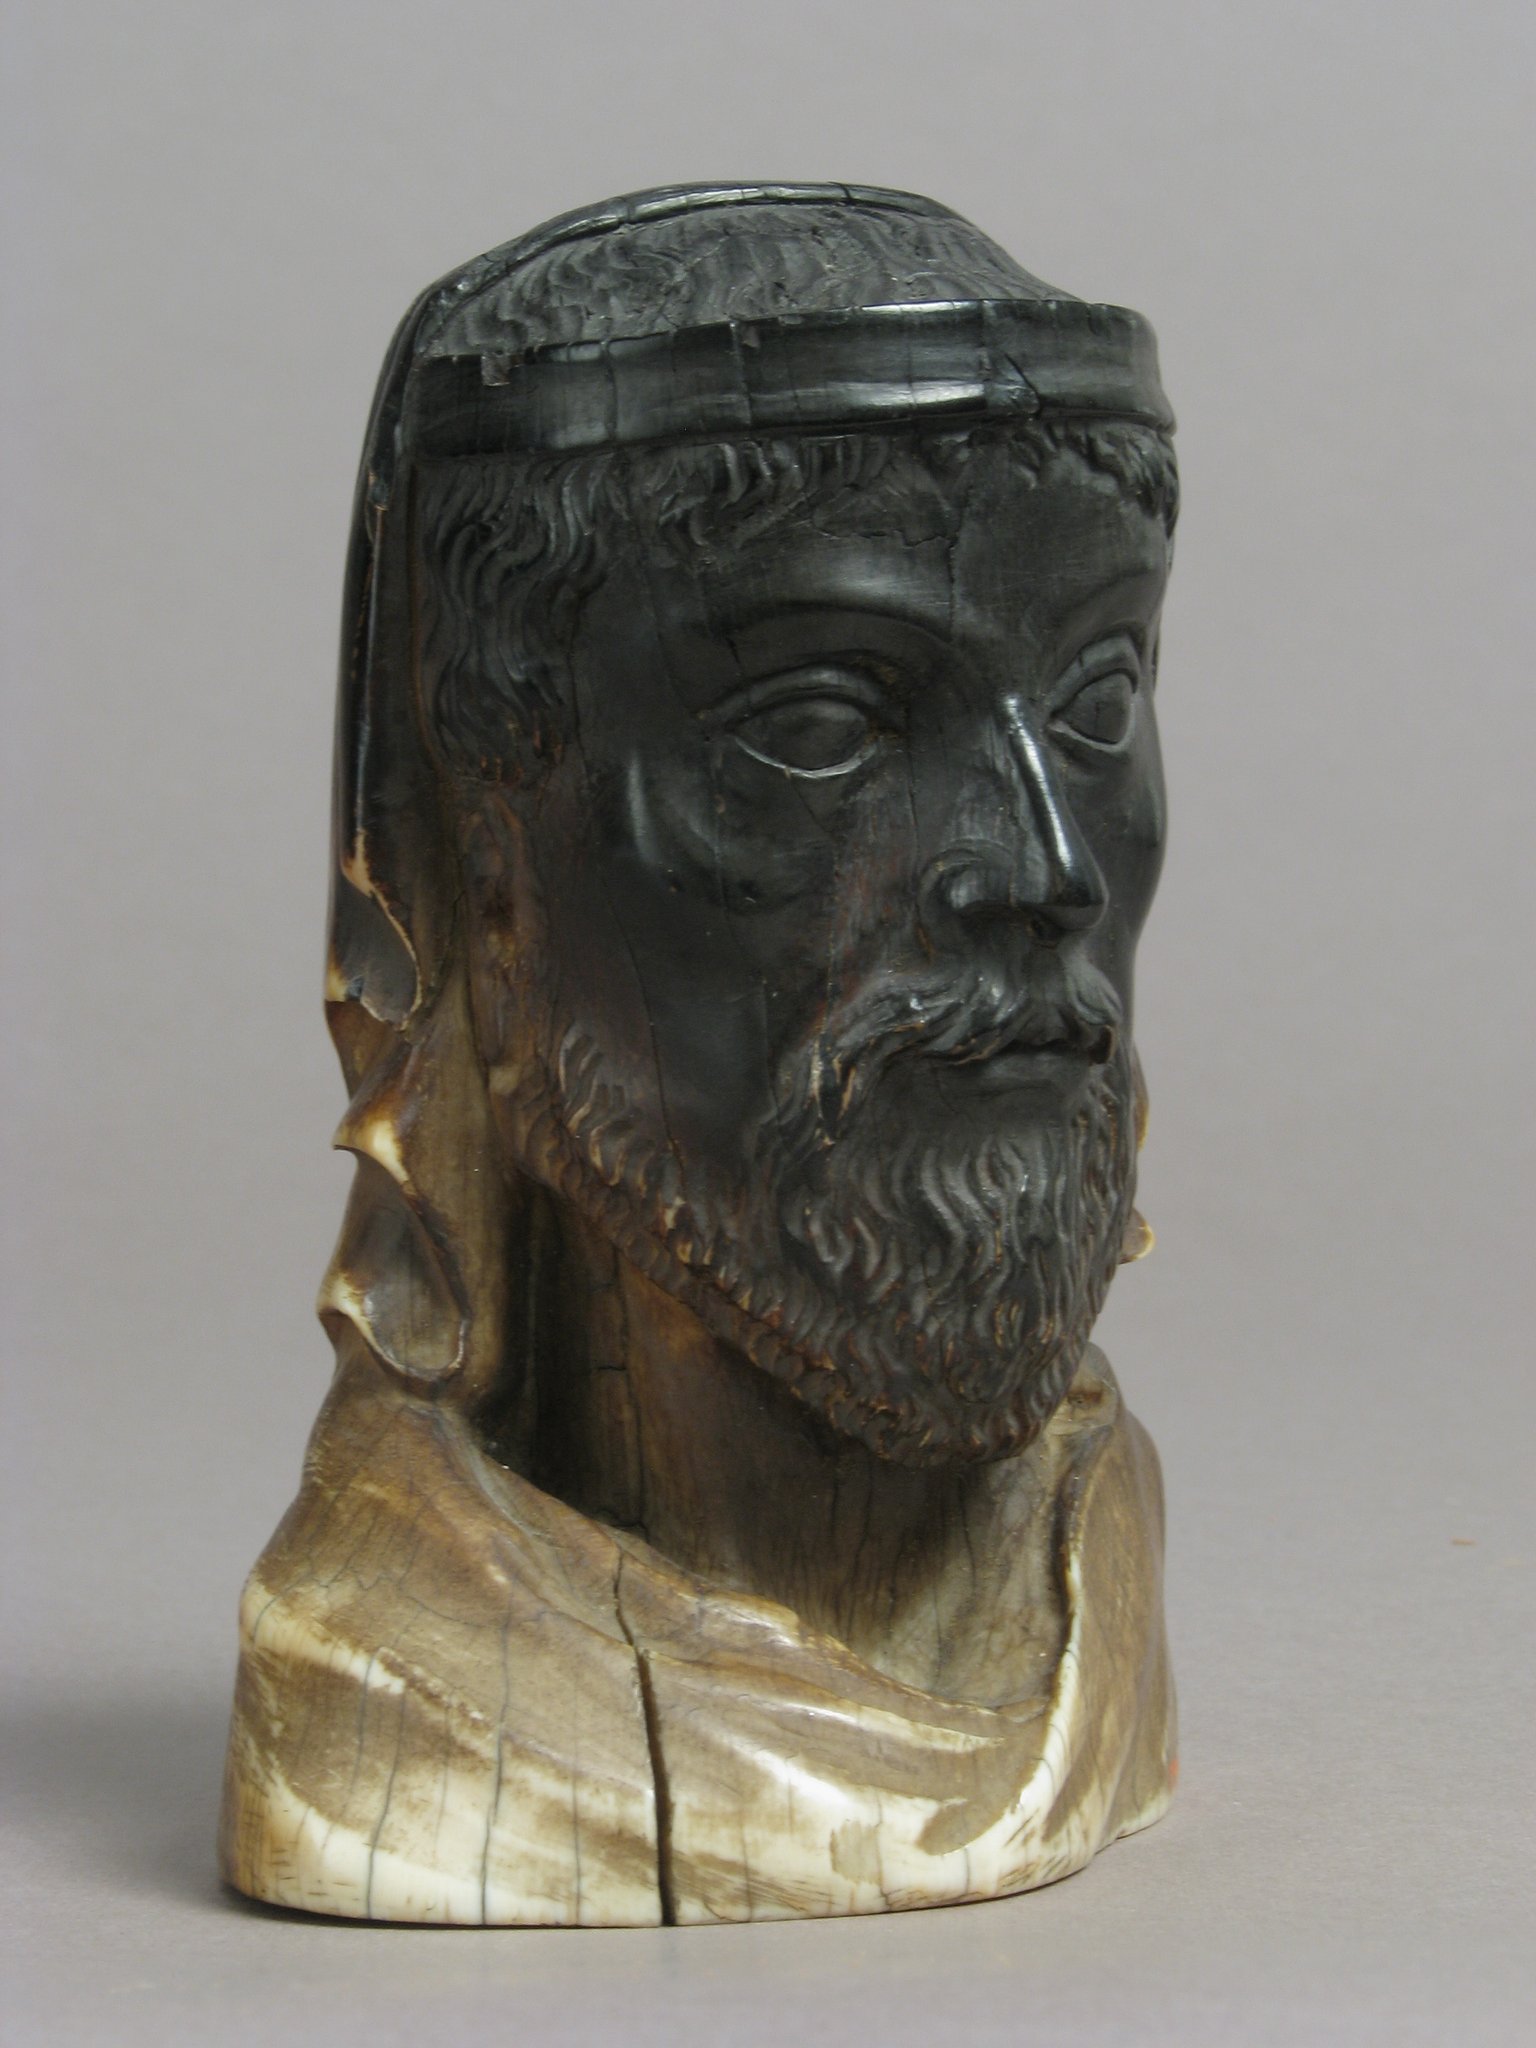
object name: head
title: Head of Christ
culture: european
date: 1801-1900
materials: ivory